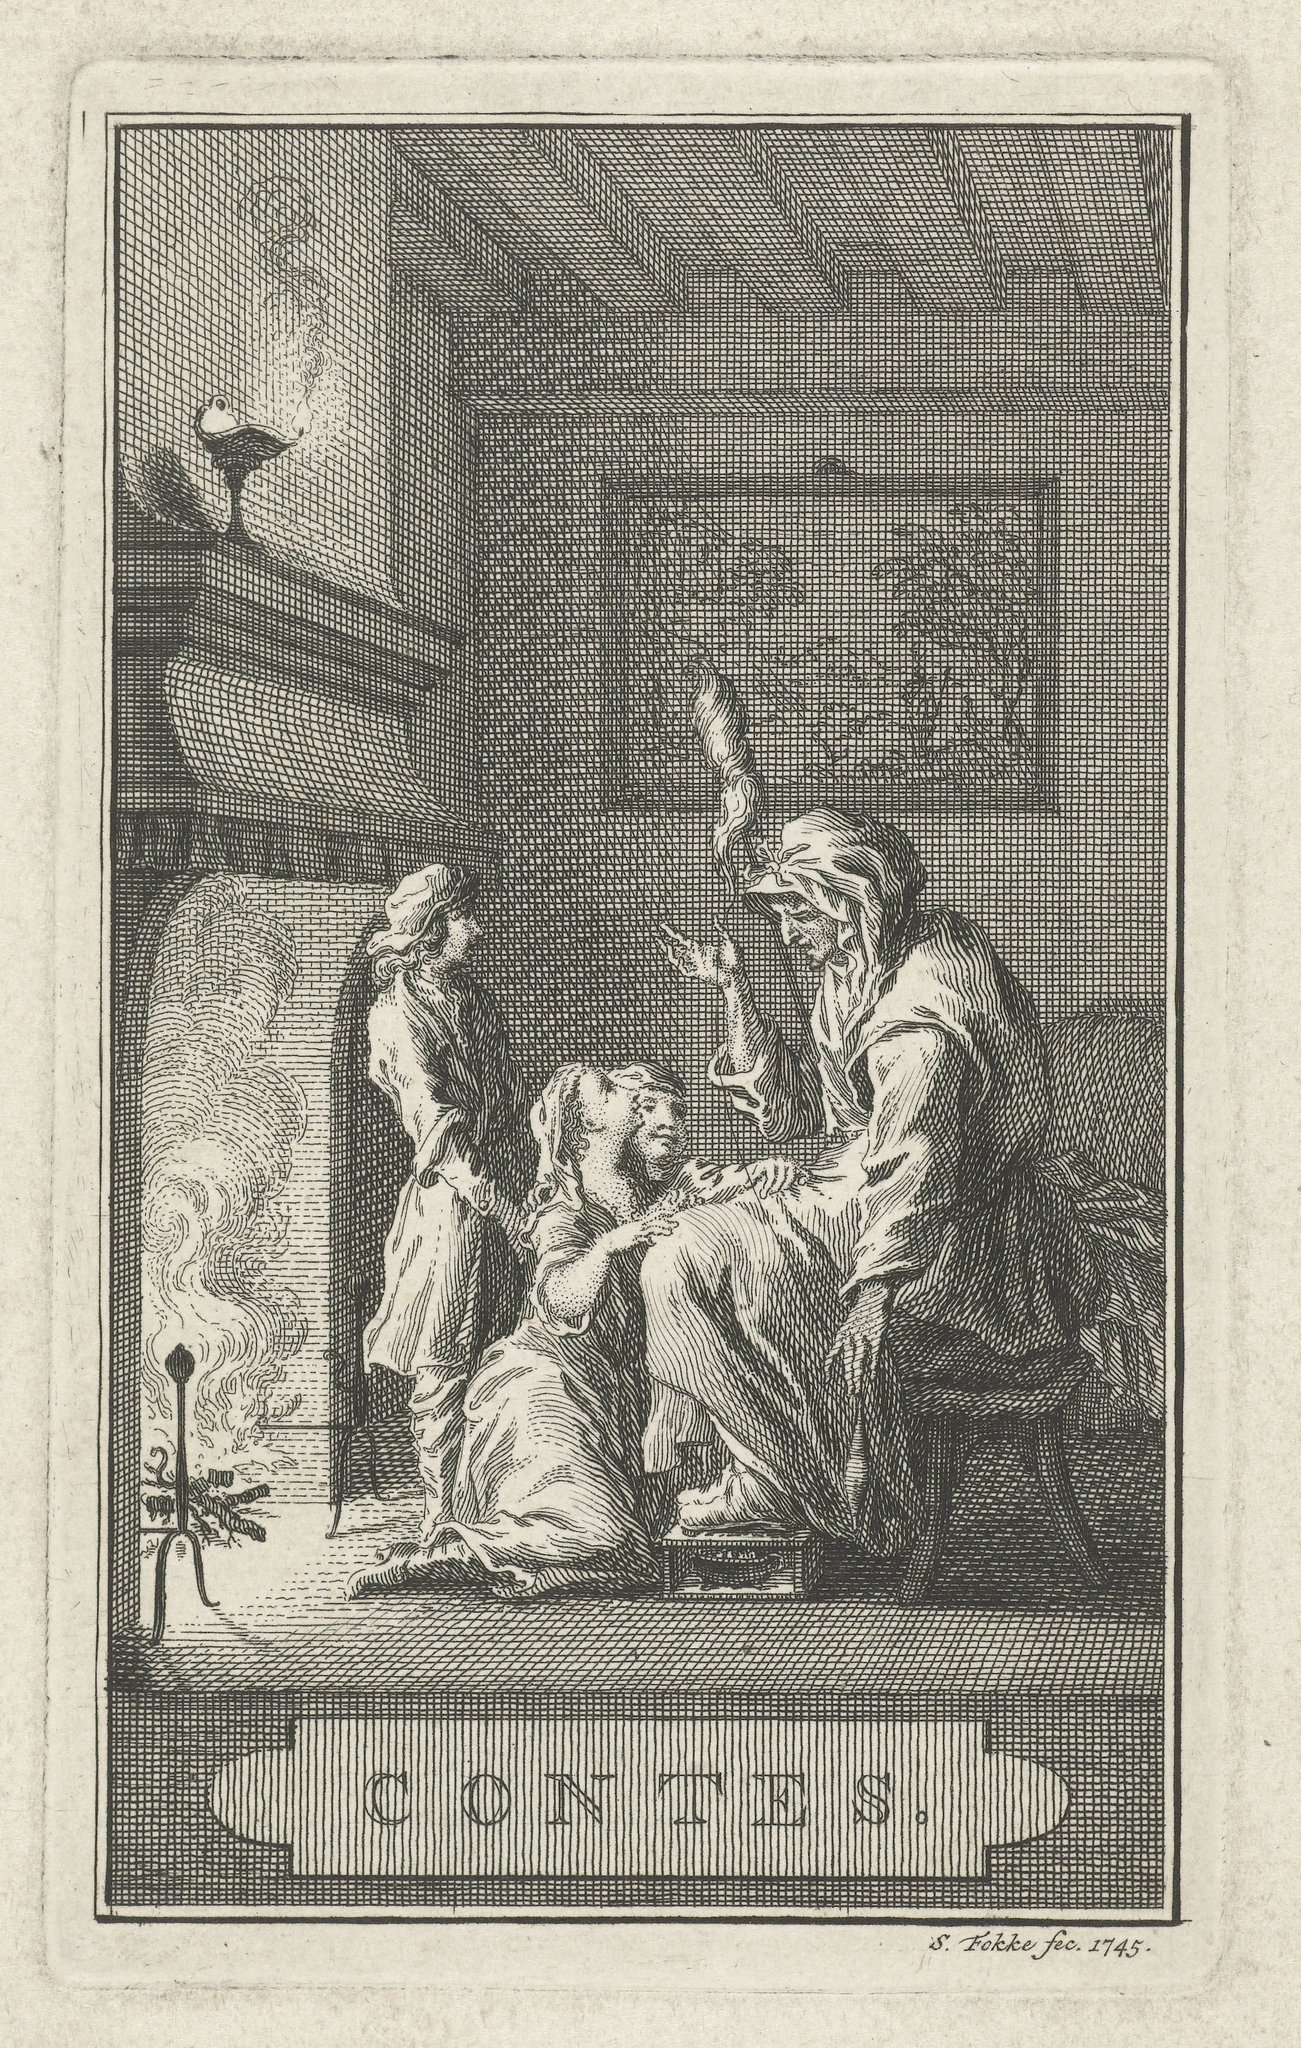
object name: print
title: Oude vrouw met drie kinderen bij openhaard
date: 1745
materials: paper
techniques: etching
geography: amsterdam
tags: open hearth, fire-place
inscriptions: collector's mark: Lugt 2228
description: Voor de openhaard zit een oude vrouw met spinrok, haar voeten rusten op een stoof. Twee kinderen zitten geknield voor haar en luisteren samen met het staande derde kind aandachtig naar de oude vrouw. Deze prent is vervaardigd bij de verhalen uit "Vertellingen van Moeder de Gans - Contes du tems passé de ma mere l’oye" van Charles Perrault.